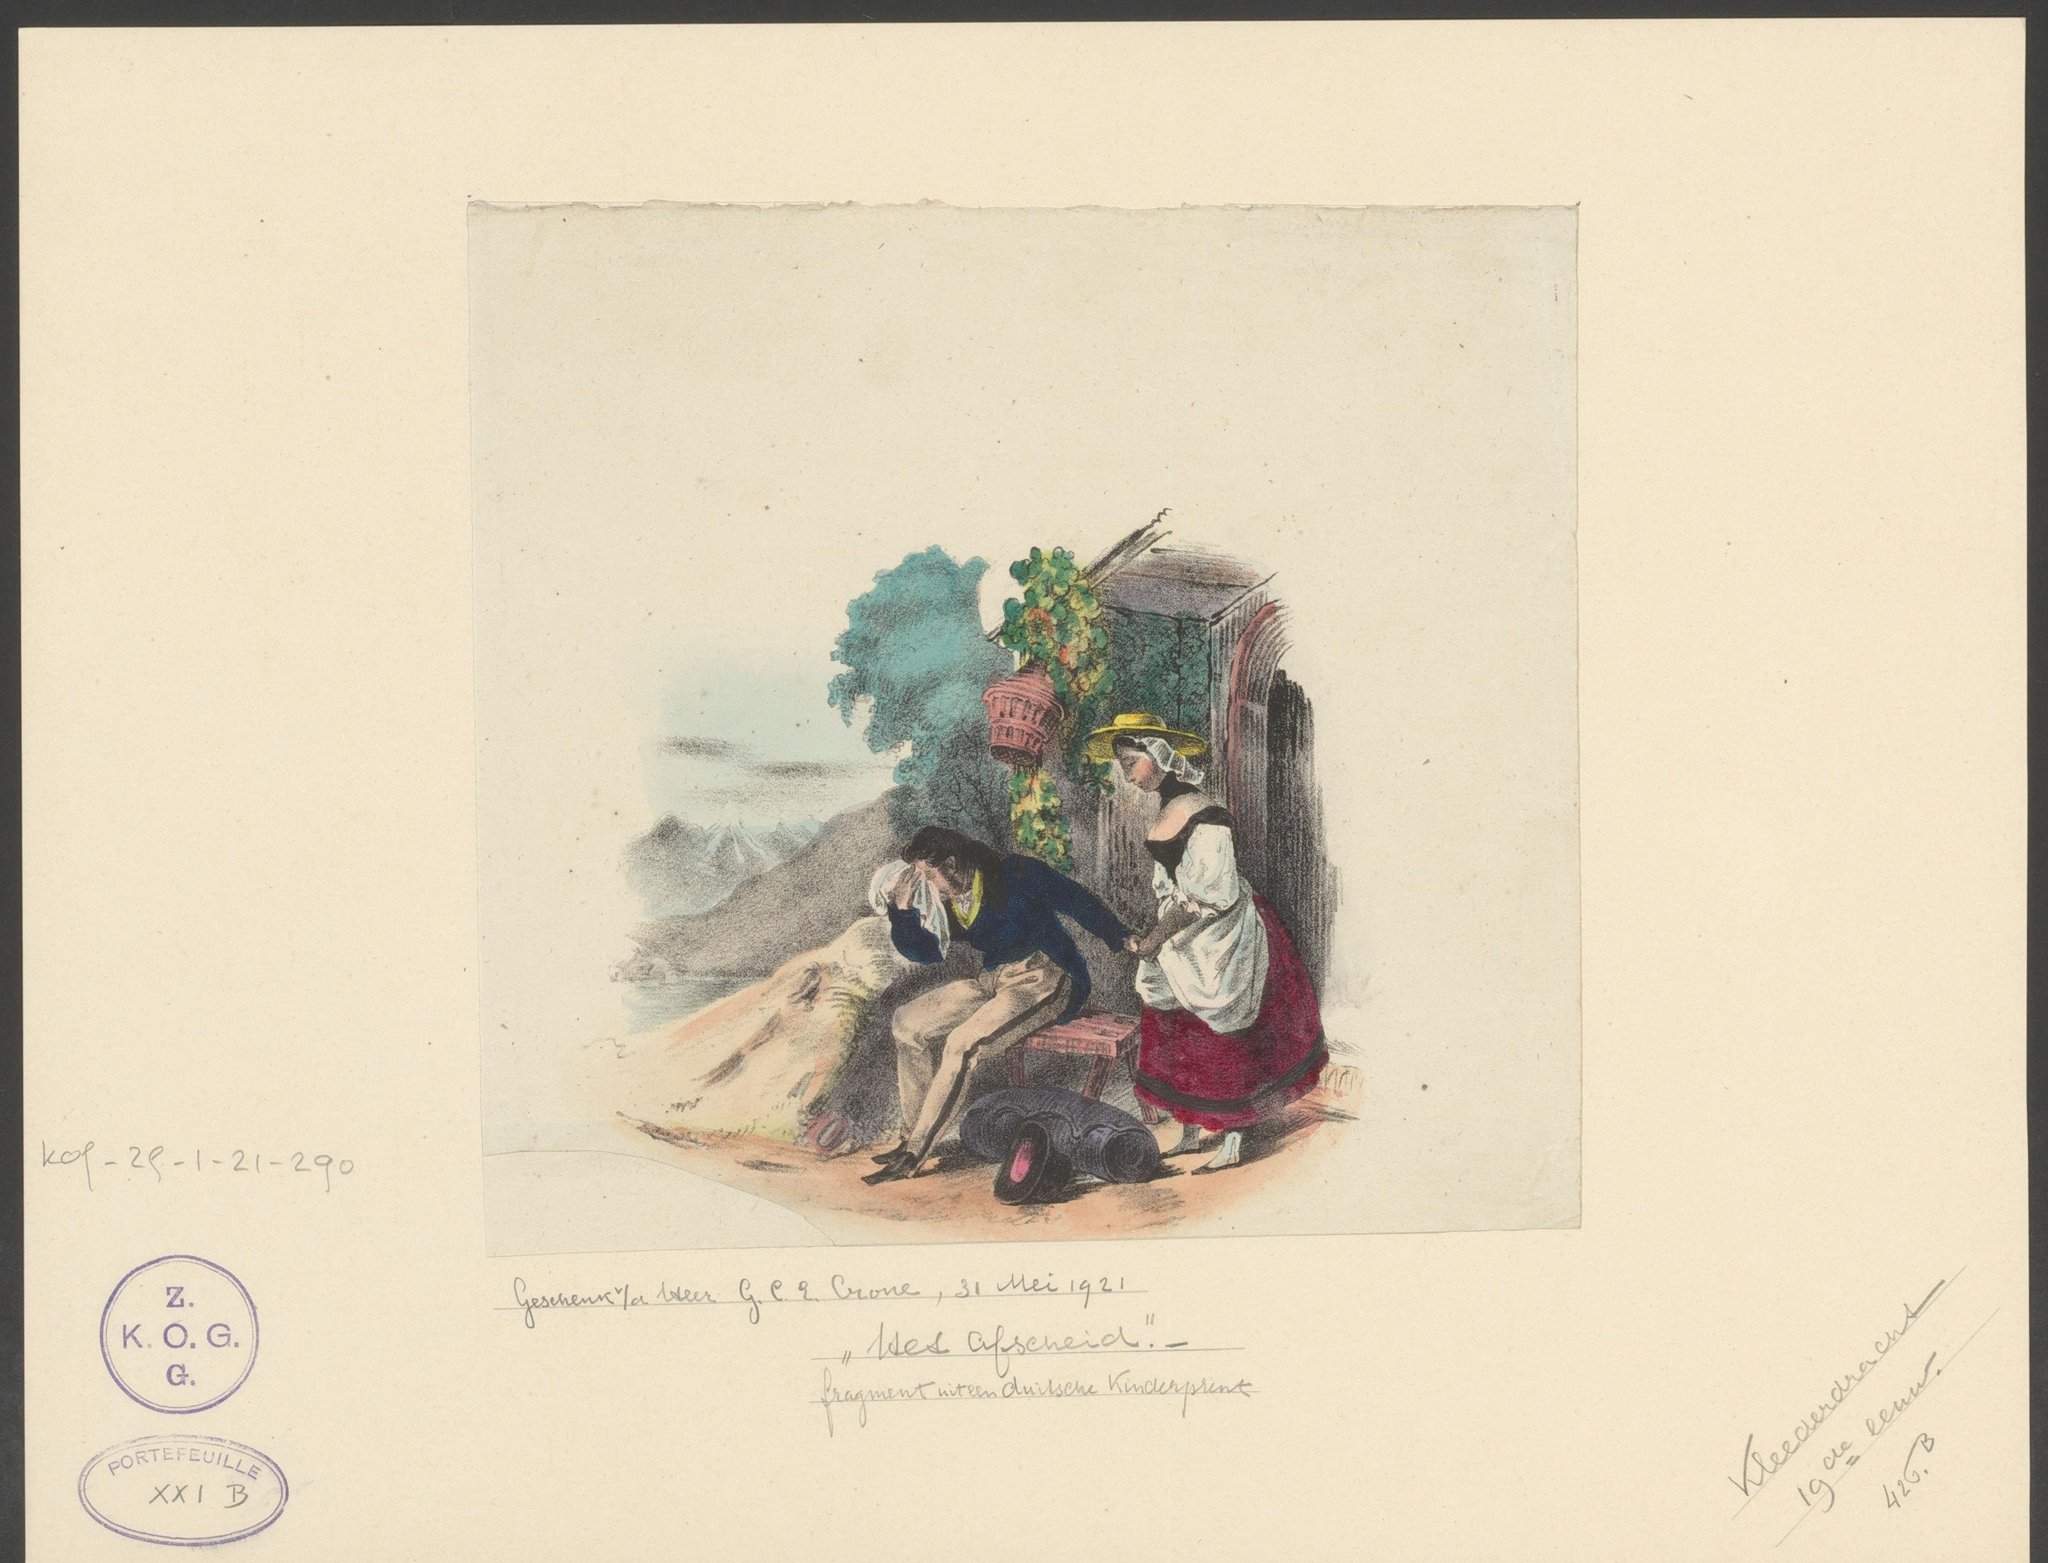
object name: print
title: Afscheid van en man en vrouw in de bergen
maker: Anonymous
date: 1800-1899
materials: paper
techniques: hand coloring, lithograph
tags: weeping, waving farewell ~ departure on a journey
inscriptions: collector's mark: Lugt 1641, stamp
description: Onderwerpsrubrieken binnen de Atlas Zeden en Gewoonten: Zeden en Gewoonten in Engeren Zin, De Kleeding, Kleederdrachten (tijdvakken), Het midden der 19de eeuw. Mannen en vrouwen.